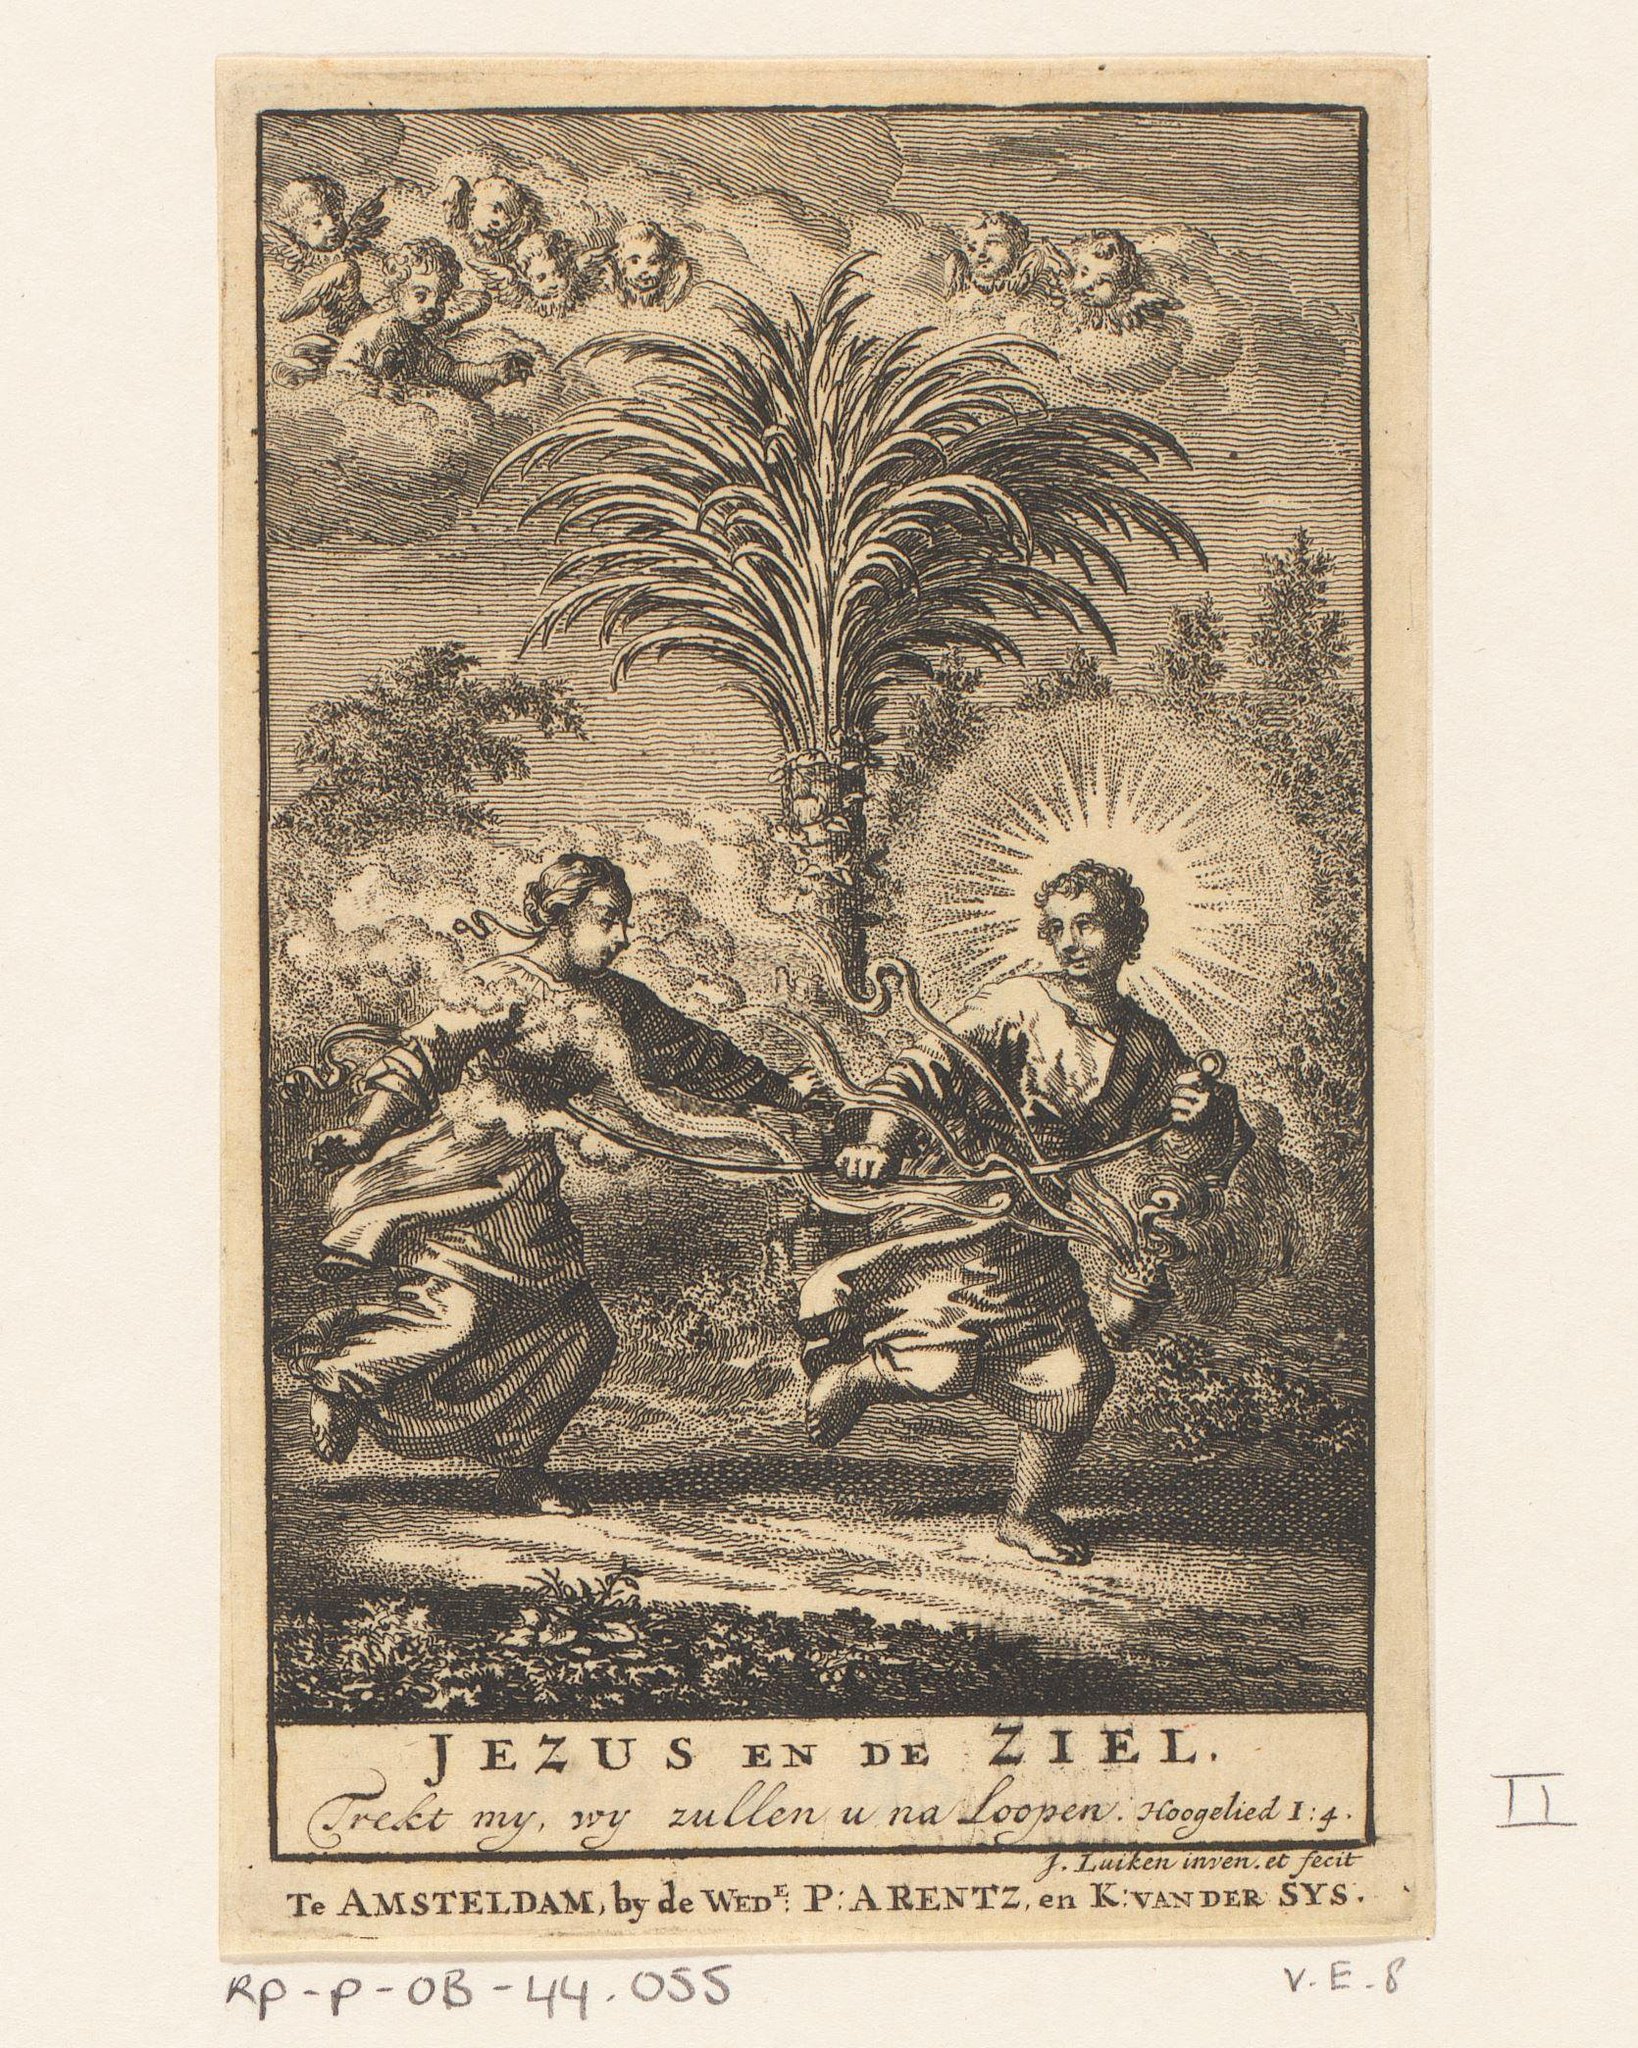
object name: print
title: Titelpagina voor: J. Luyken, Jezus en de Ziel, 1704-1714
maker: jan luyken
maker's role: draughtsman, print maker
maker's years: 1649-1712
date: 1704-1714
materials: paper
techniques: etching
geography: amsterdam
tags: christ as youth, the soul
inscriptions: collector's mark: Lugt 240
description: Titelpagina voor: Luyken, Jan. Jezus en de Ziel, 3 delen. Amsterdam: Wed. Pieter Arentsz II en Cornelis van der Sys, 1704-1714.